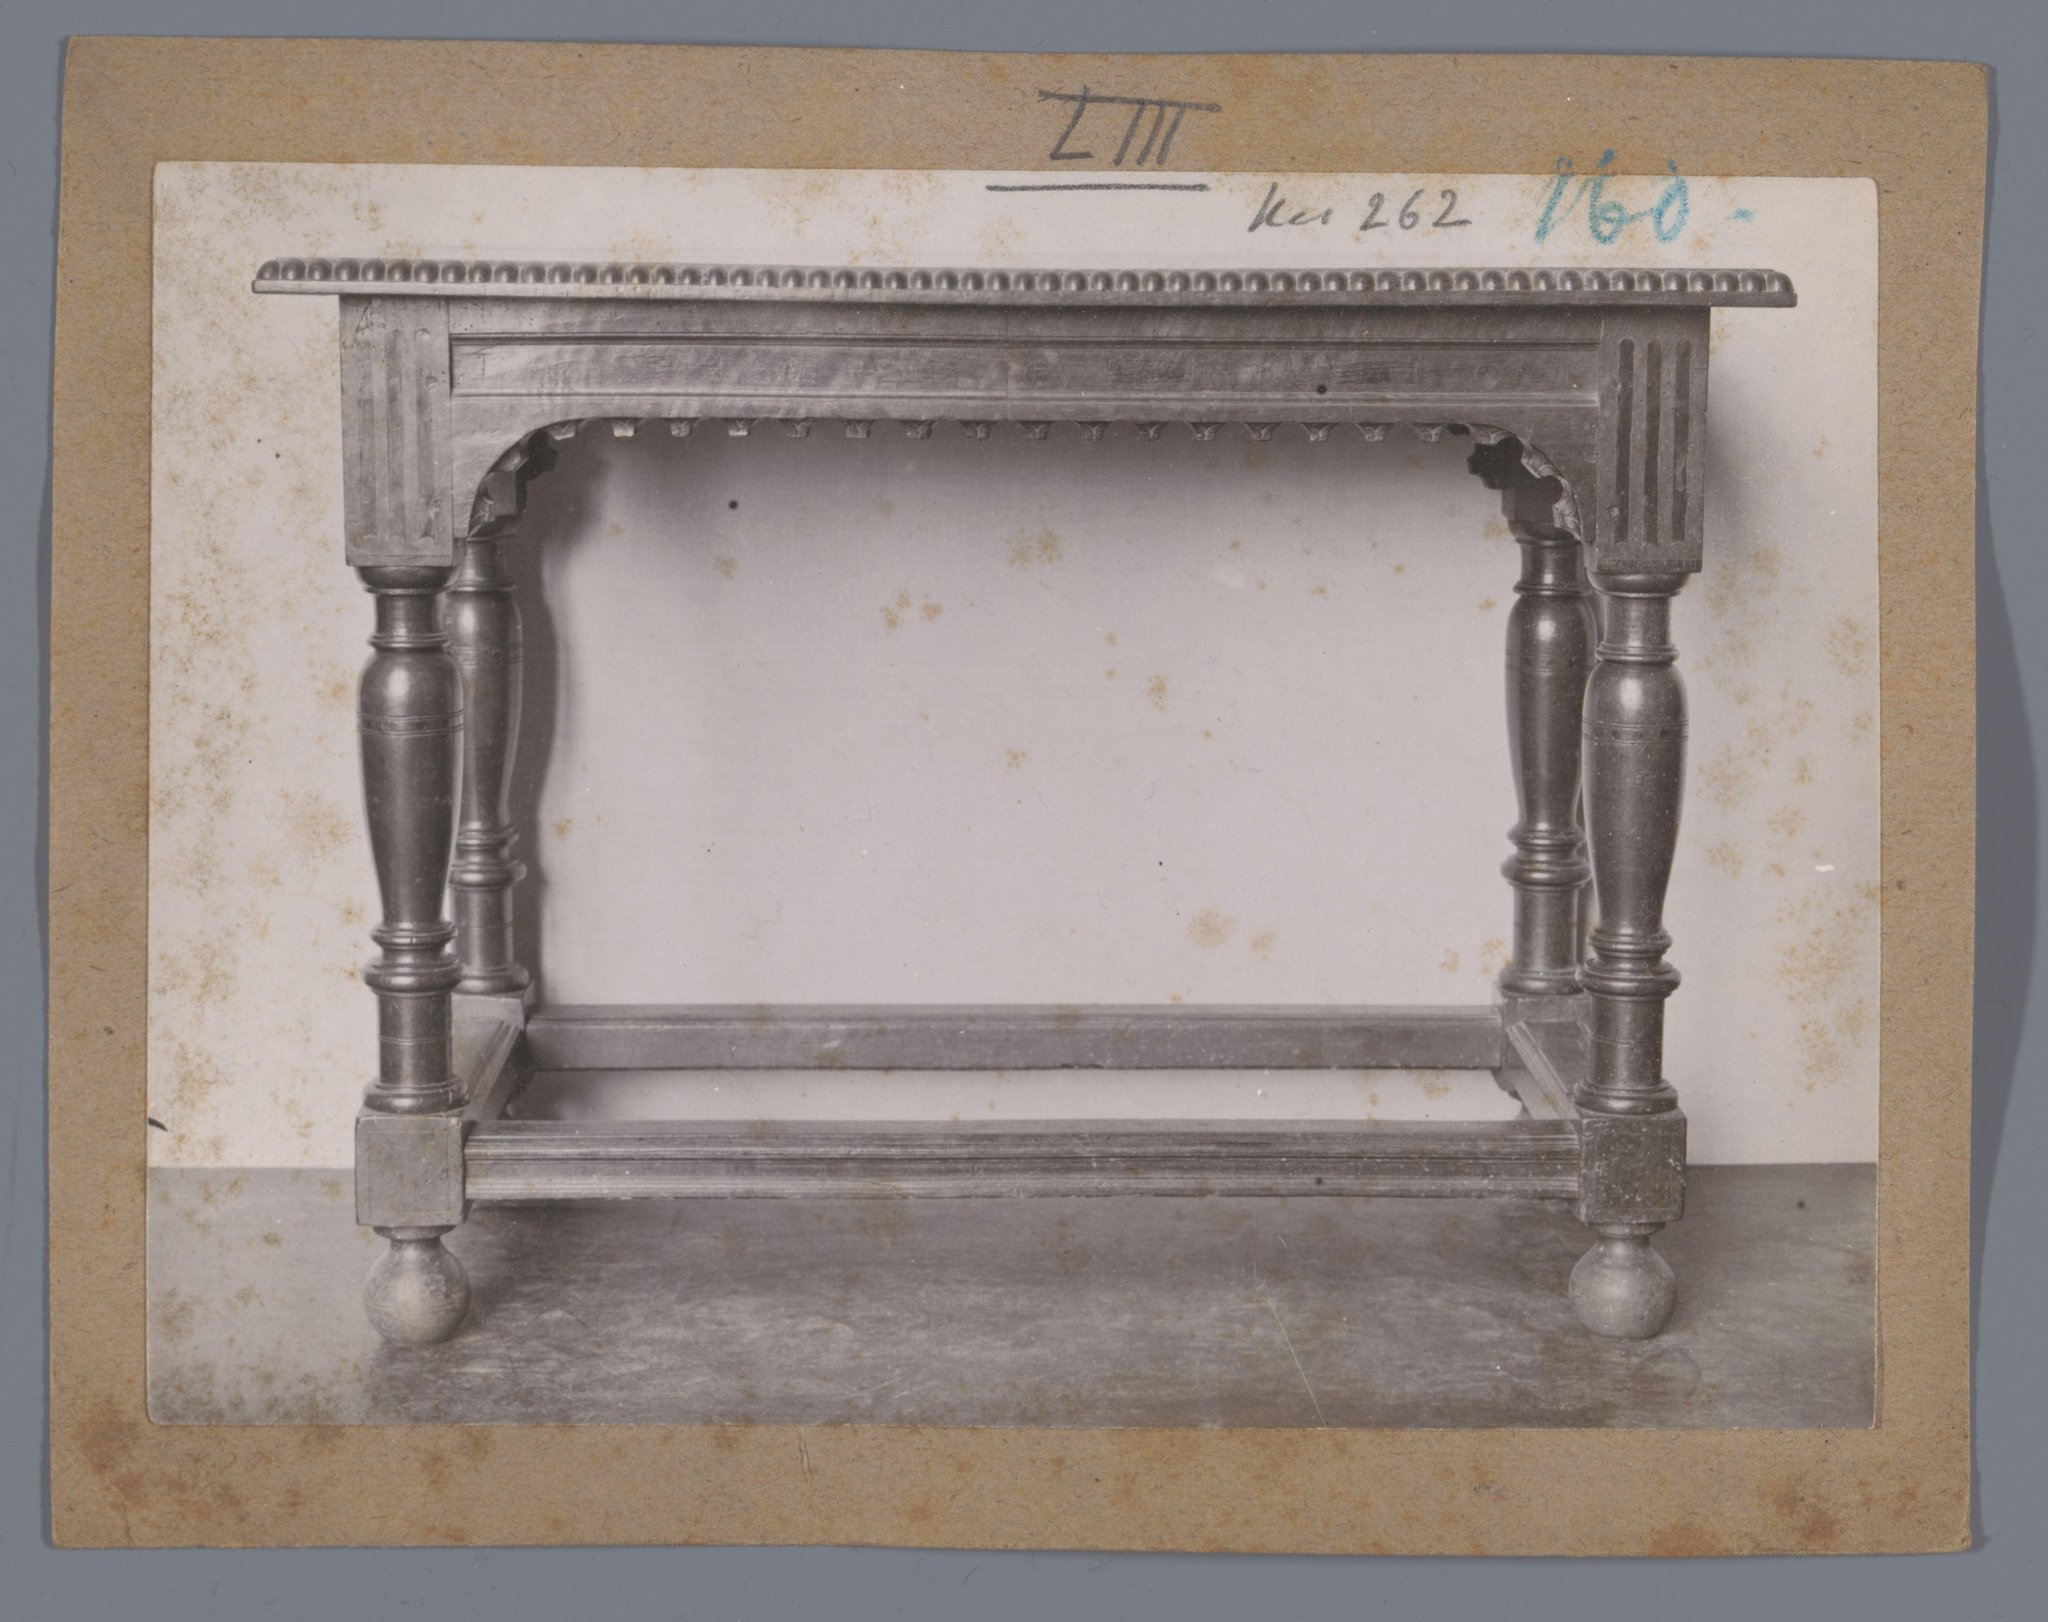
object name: photograph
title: Tafel (vermoedelijk) in het Rijksmuseum te Amsterdam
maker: Anonymous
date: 1875-1900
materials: photographic support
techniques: matte daylight collodion silver print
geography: amsterdam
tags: table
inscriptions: collector's mark: ‘Kunstnijverheidschool Quellinus Amsterdam Frans Halsstraat 14.’, collector's mark: ‘Instituut voor kunst-nijverheidsonderwijs Gabriël Metsustraat No. 16, Amsterdam’, number: ‘LIII kat 262 160.’